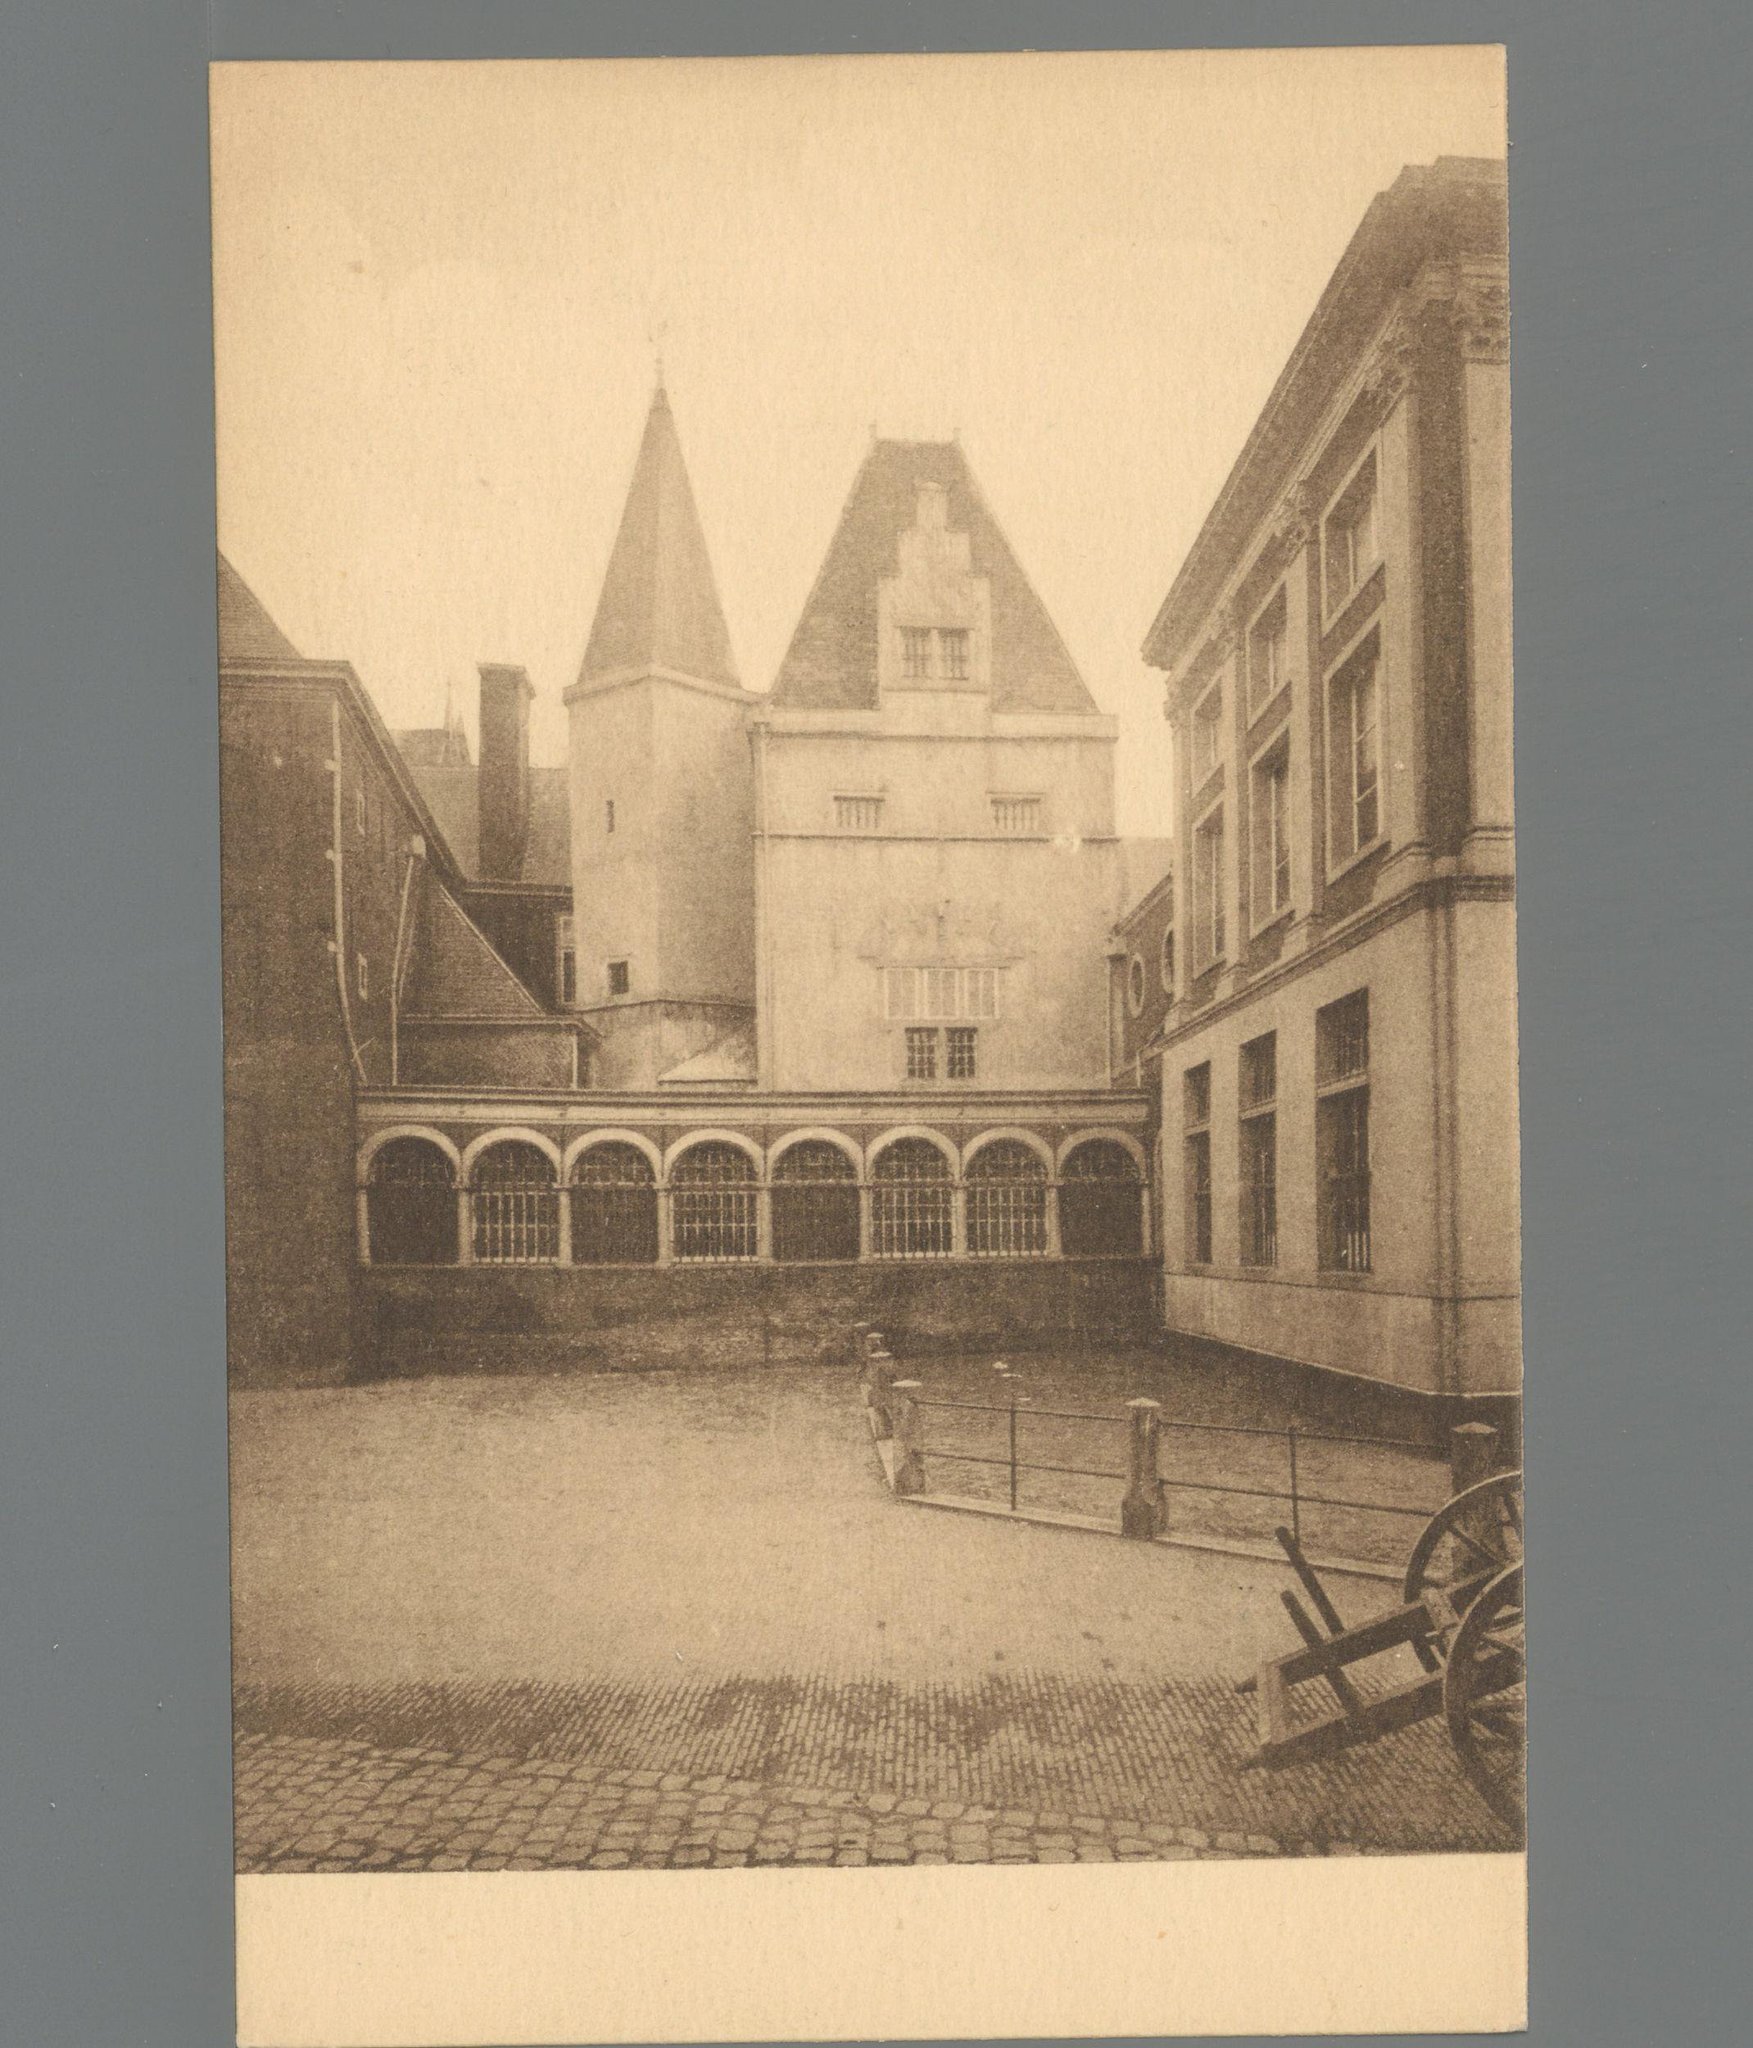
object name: photomechanical print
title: Leiden. Gravenstein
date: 1905-1930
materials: cardboard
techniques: photograph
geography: leiden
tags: prison, jail